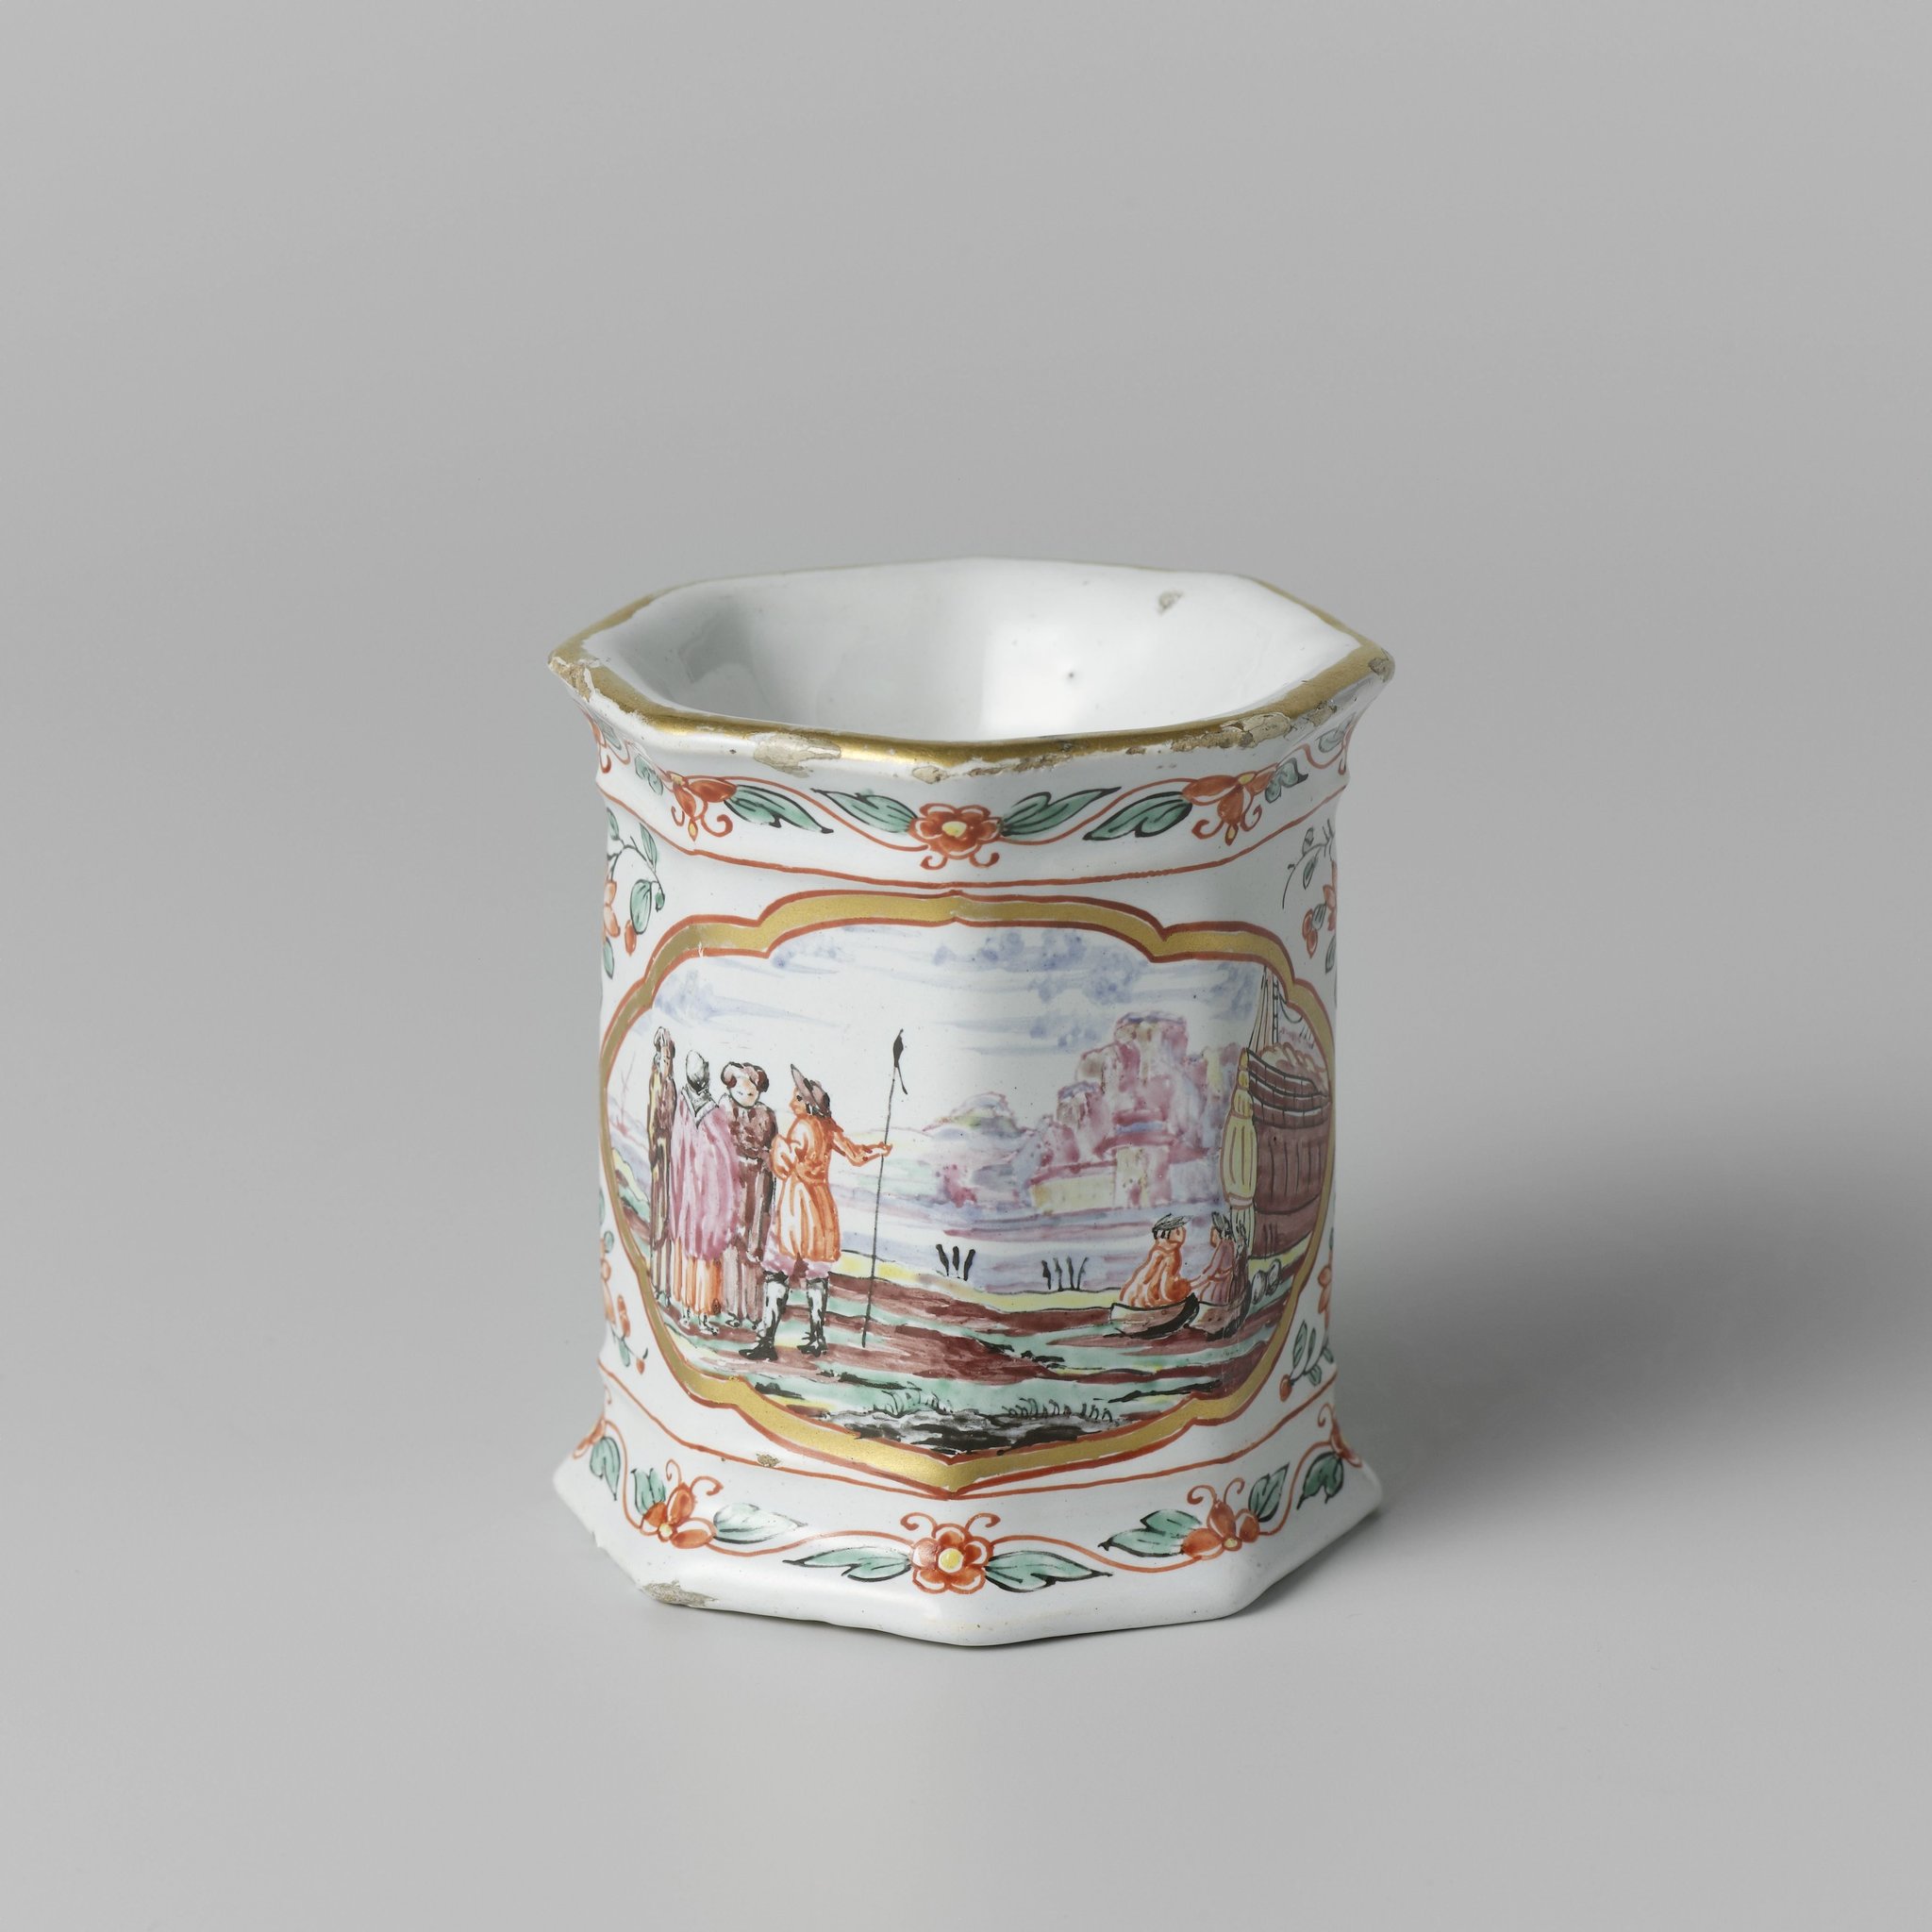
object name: salt condiment vessel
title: Salt cellar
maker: Anonymous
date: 1740-1765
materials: earthenware, glaze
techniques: kiln, painted, polychromy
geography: delft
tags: landscapes in the temperate zone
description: Achthoekig zoutvat, veelkleurig beschilderd met een mediterraans landschap in een cartouche.